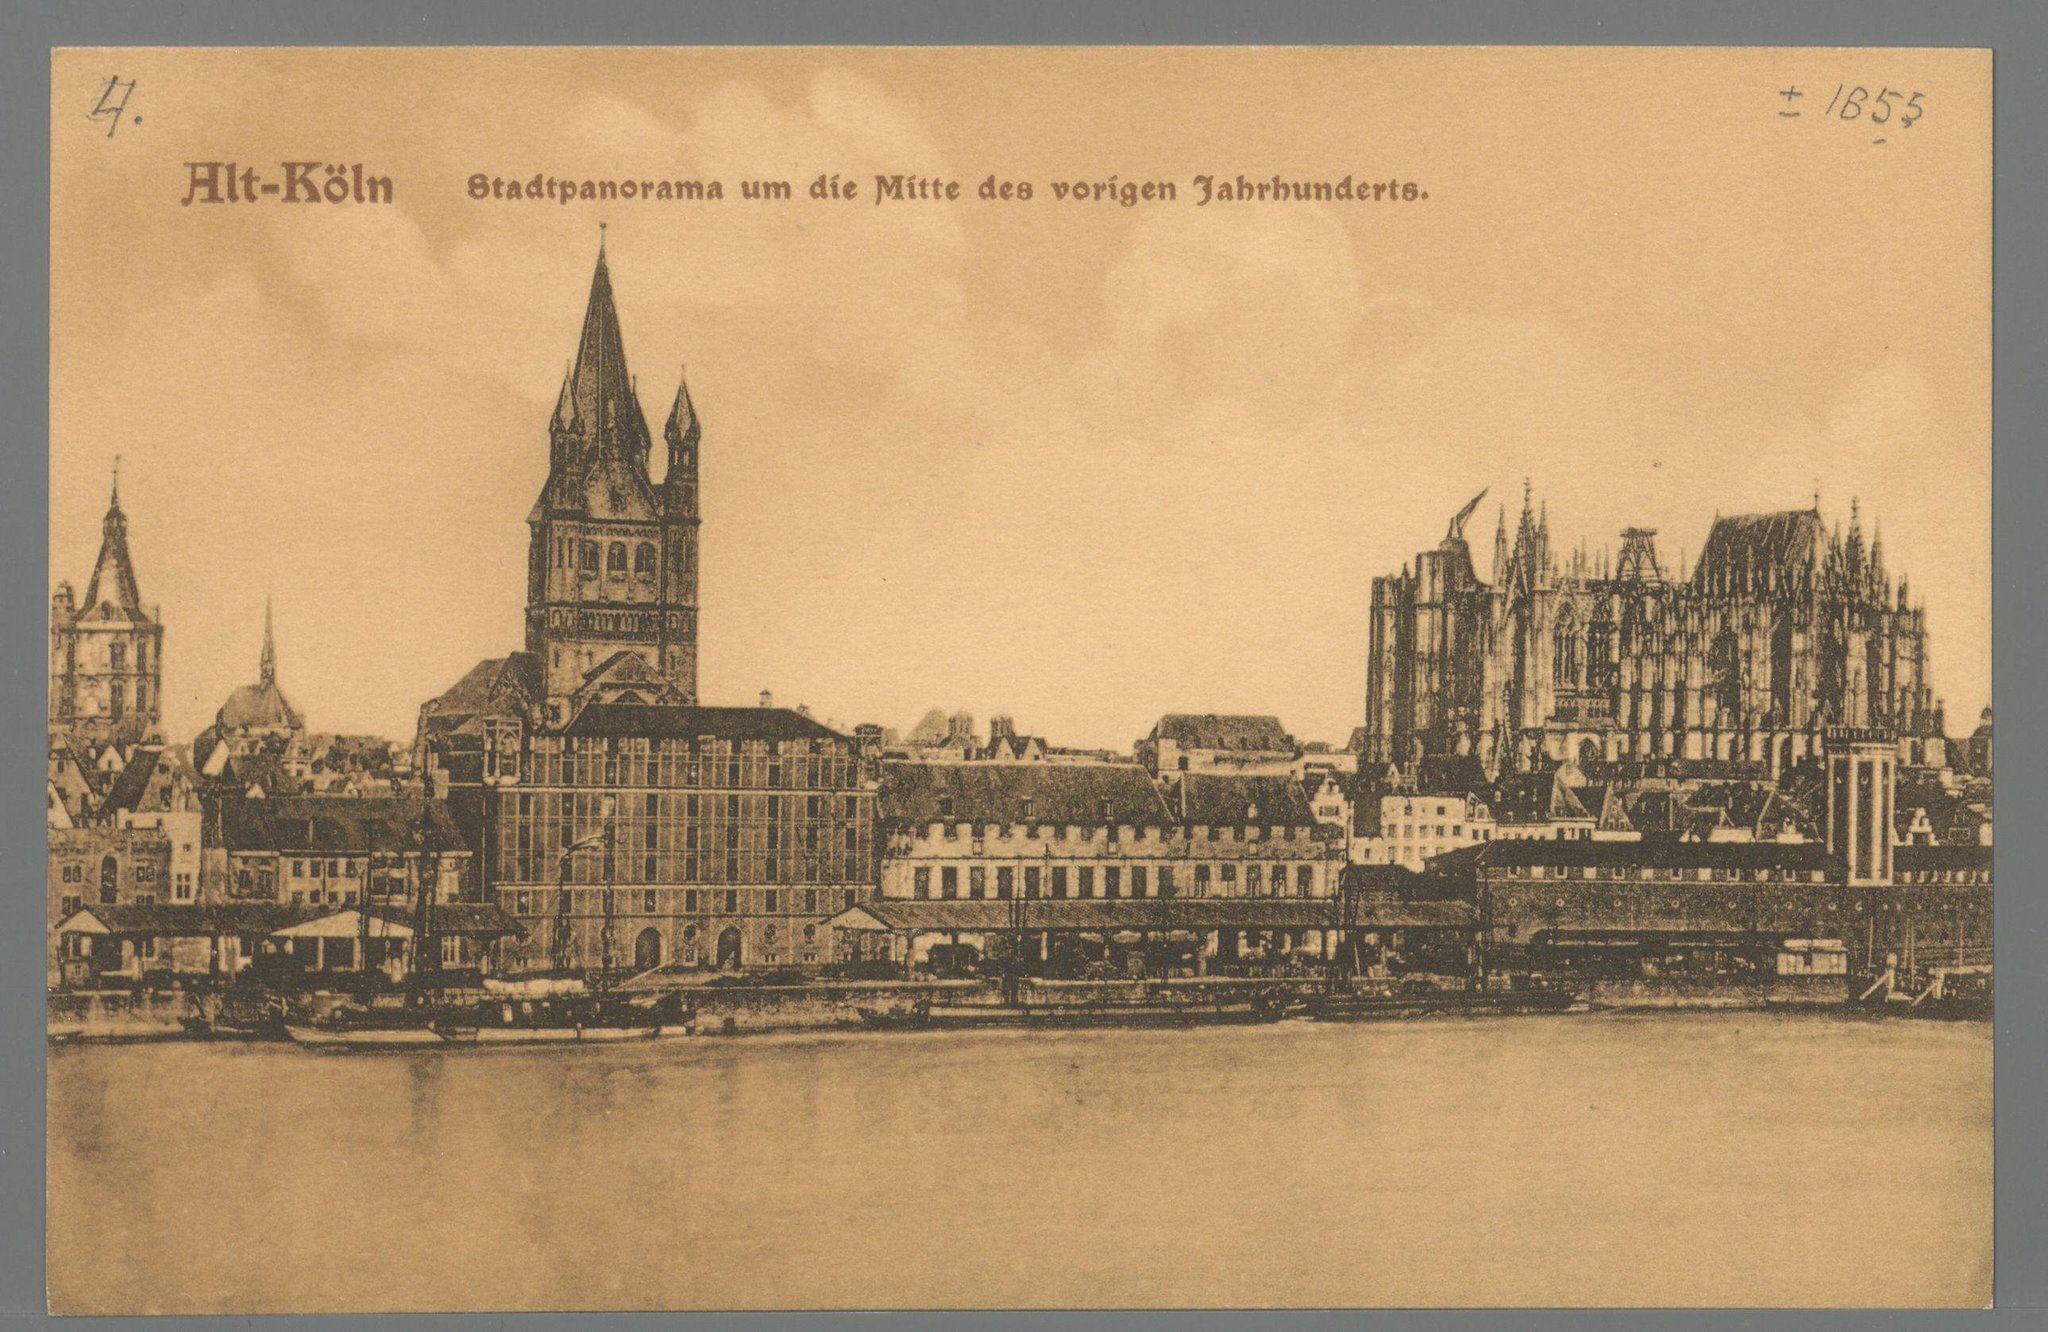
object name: ansichtkaart, prentbriefkaart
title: Alt-Köln. Stadtpanorama um die Mitte des vorigen Jahrhunderts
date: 1905-1920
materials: cardboard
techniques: photograph, writing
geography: cologne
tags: church (exterior), canals, waters (in city), prospect of city, town panorama, silhouette of city, cologne